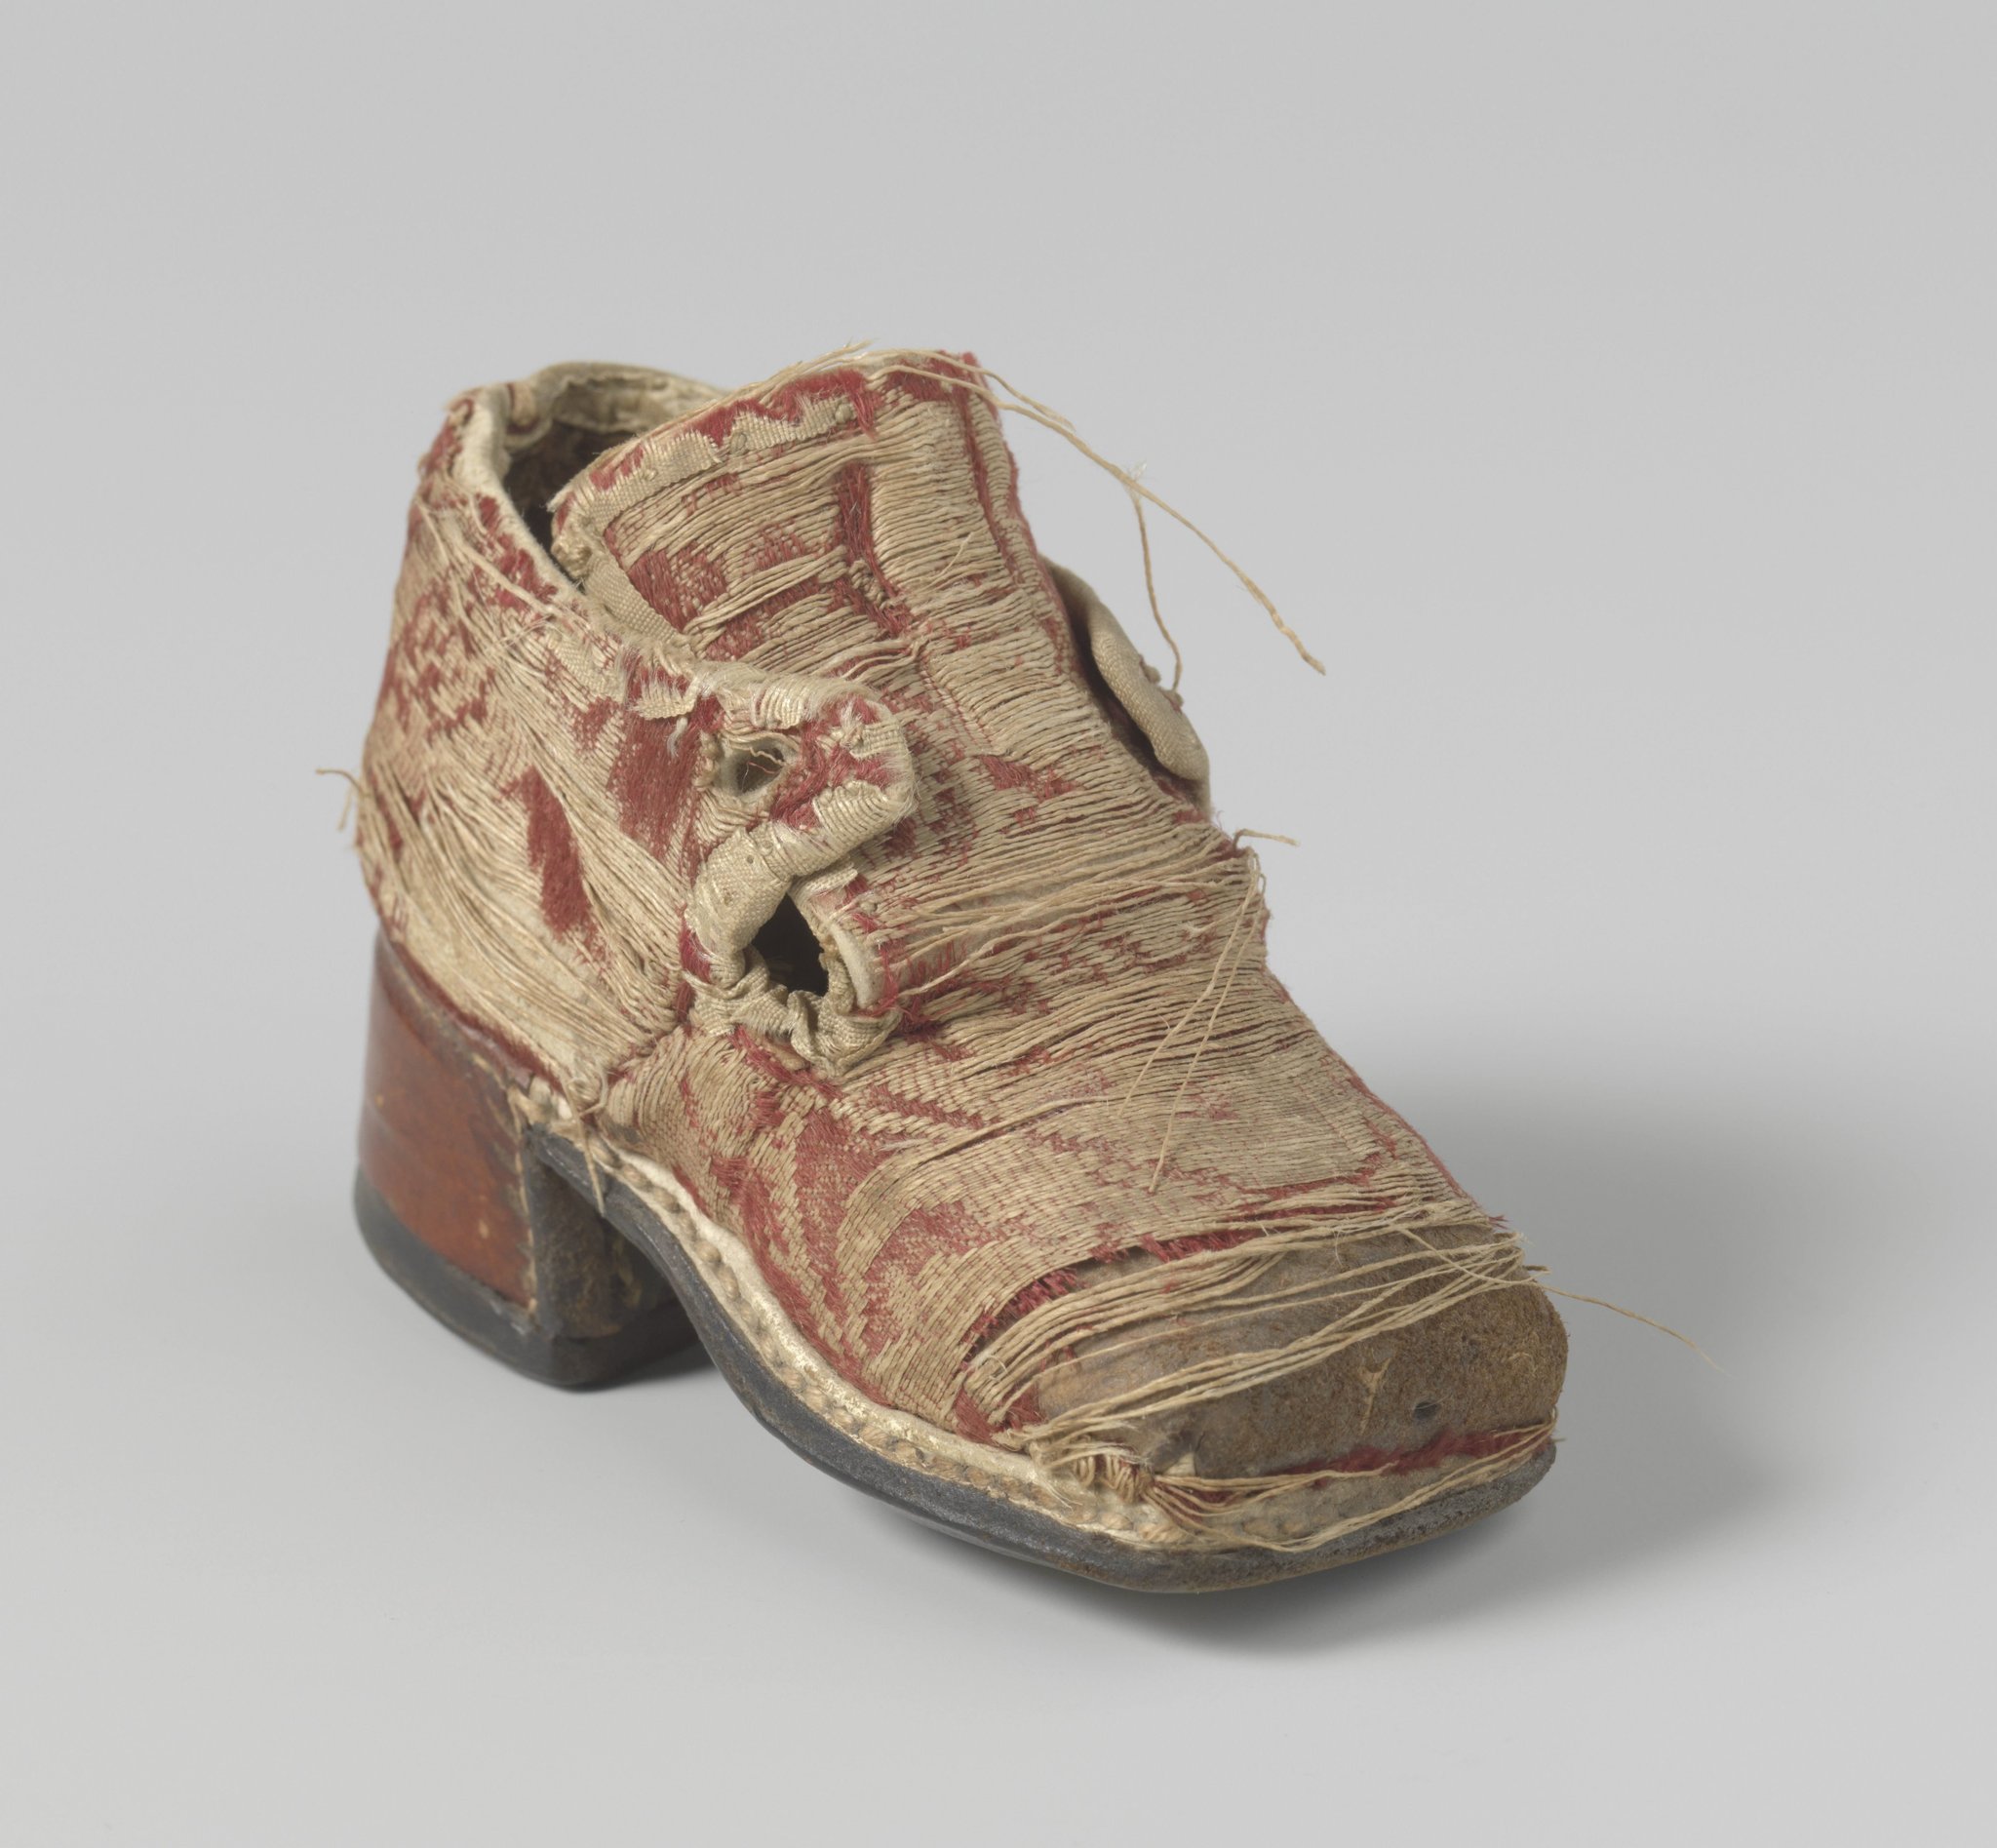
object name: doll's clothing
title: Schoen van gebrocheerde zijde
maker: Anonymous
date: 1680-1690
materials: leather, silk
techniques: brocade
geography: netherlands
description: Poppenschoen van rode gebrocheerde zijde, rode, vrij hoge hak. Vierkante neus, hoog oplopend voorblad, waarover twee lippen sluiten. De hak is overtrokken met rood leer,